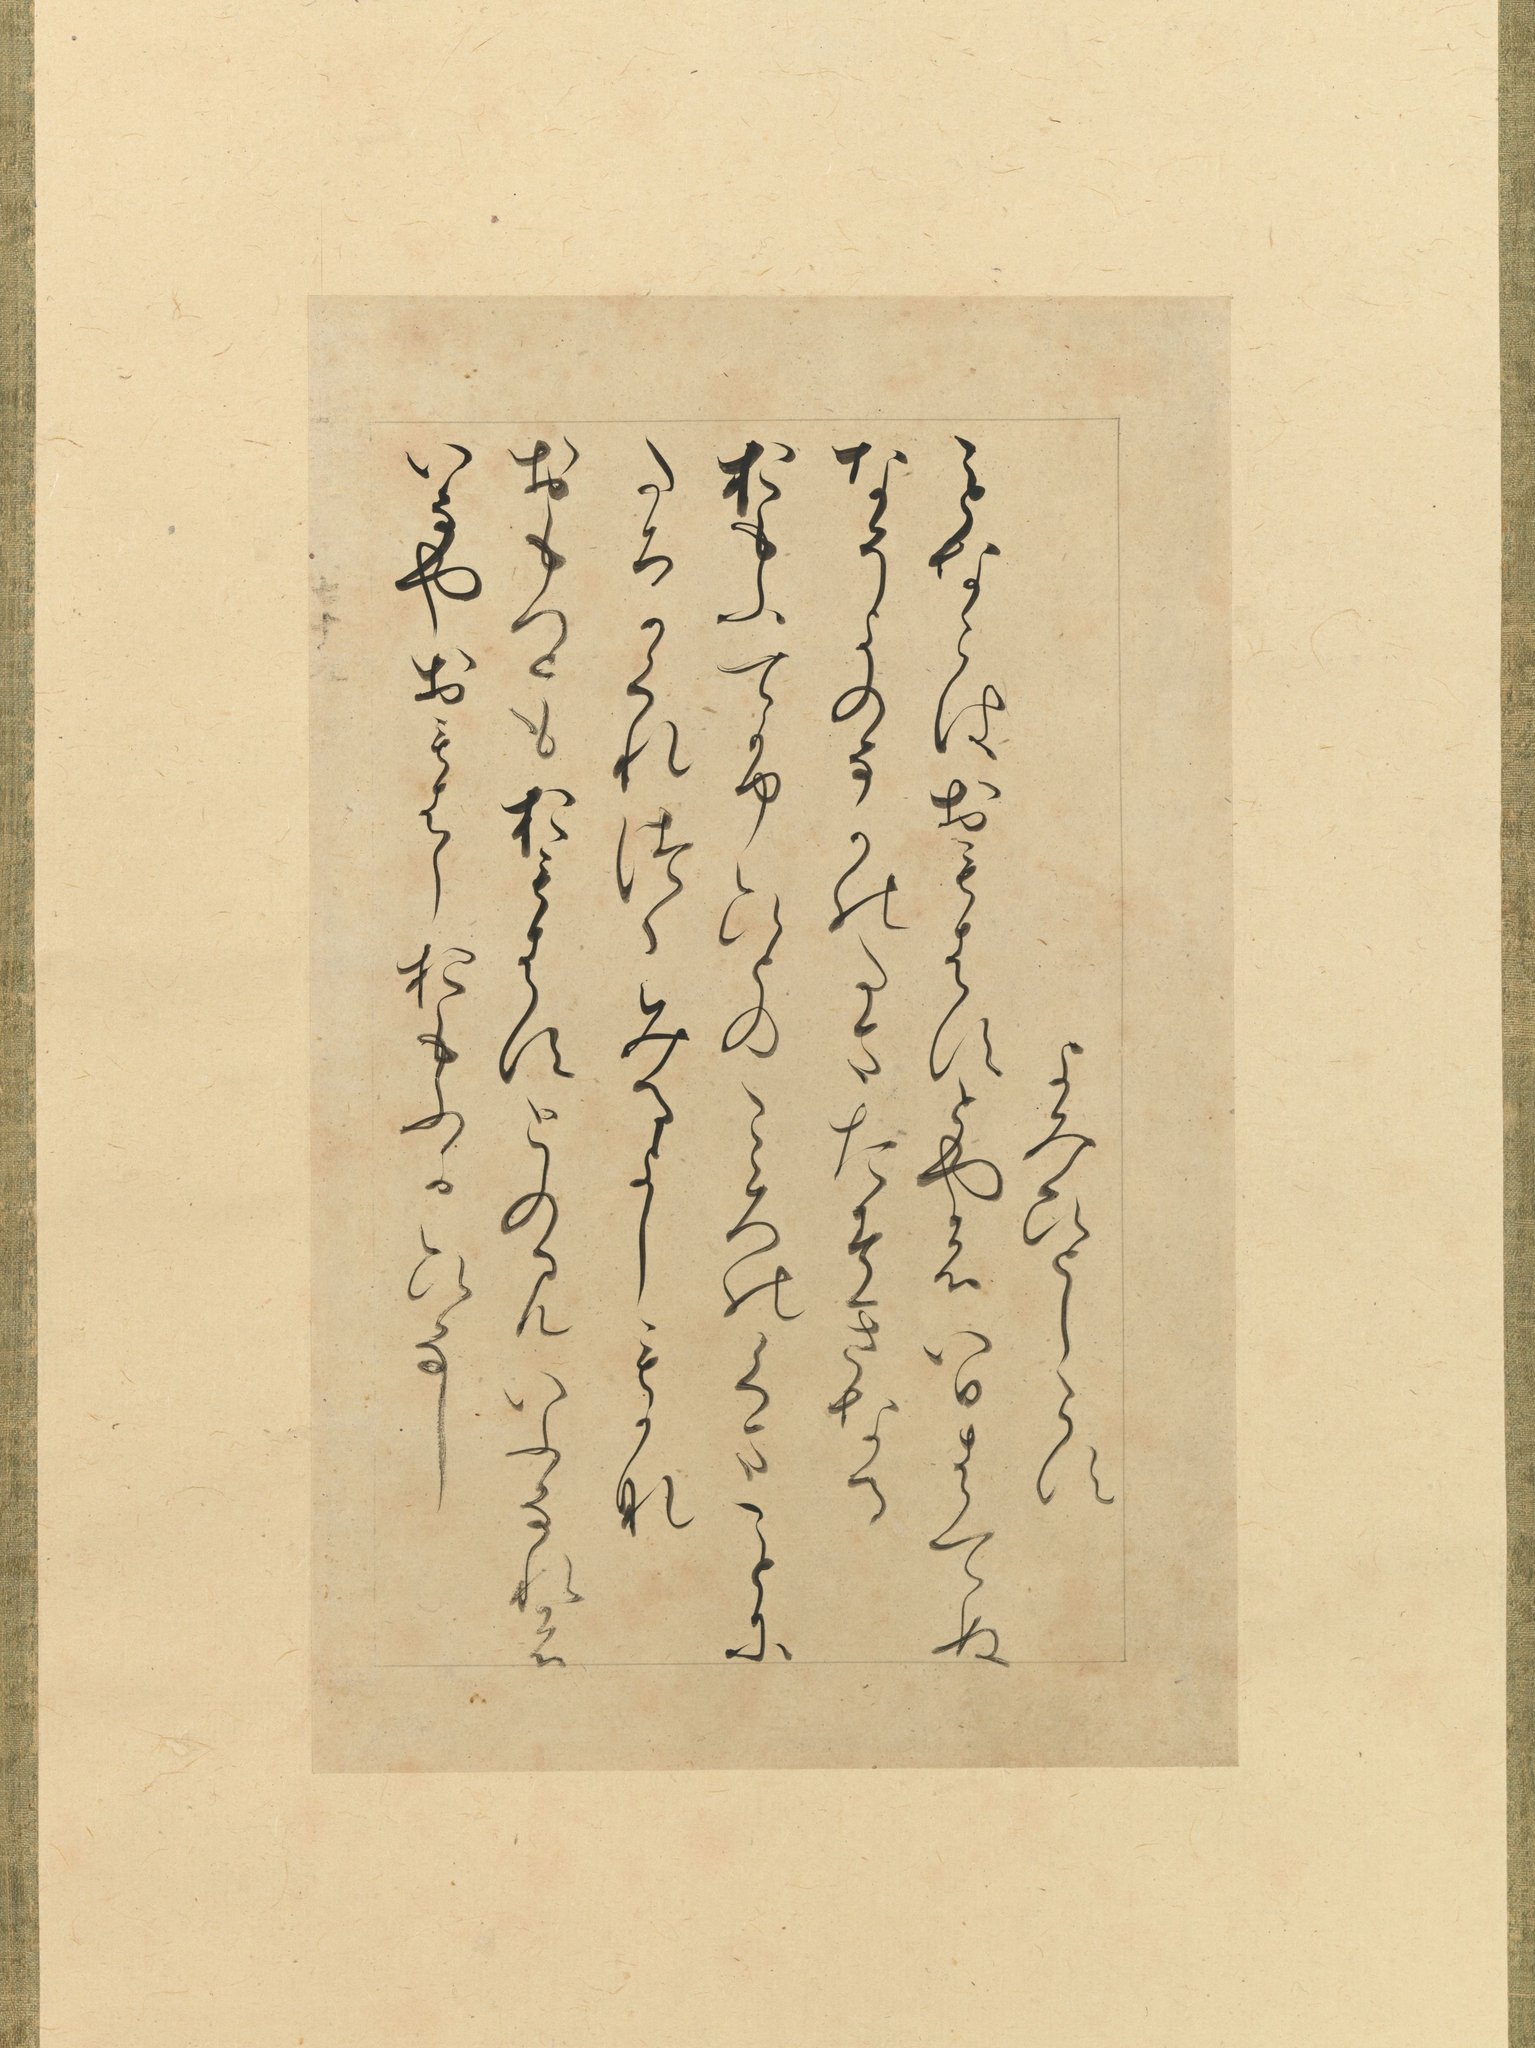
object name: hanging scroll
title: Three poems from the Collection of Poems Ancient and Modern (Kokin wakashū), known as the “Imaki Fragment” (Imaki-gire)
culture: japanese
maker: fujiwara no norinaga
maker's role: artist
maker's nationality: japanese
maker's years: 1109-1180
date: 1101-1200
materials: ink, paper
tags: poetry